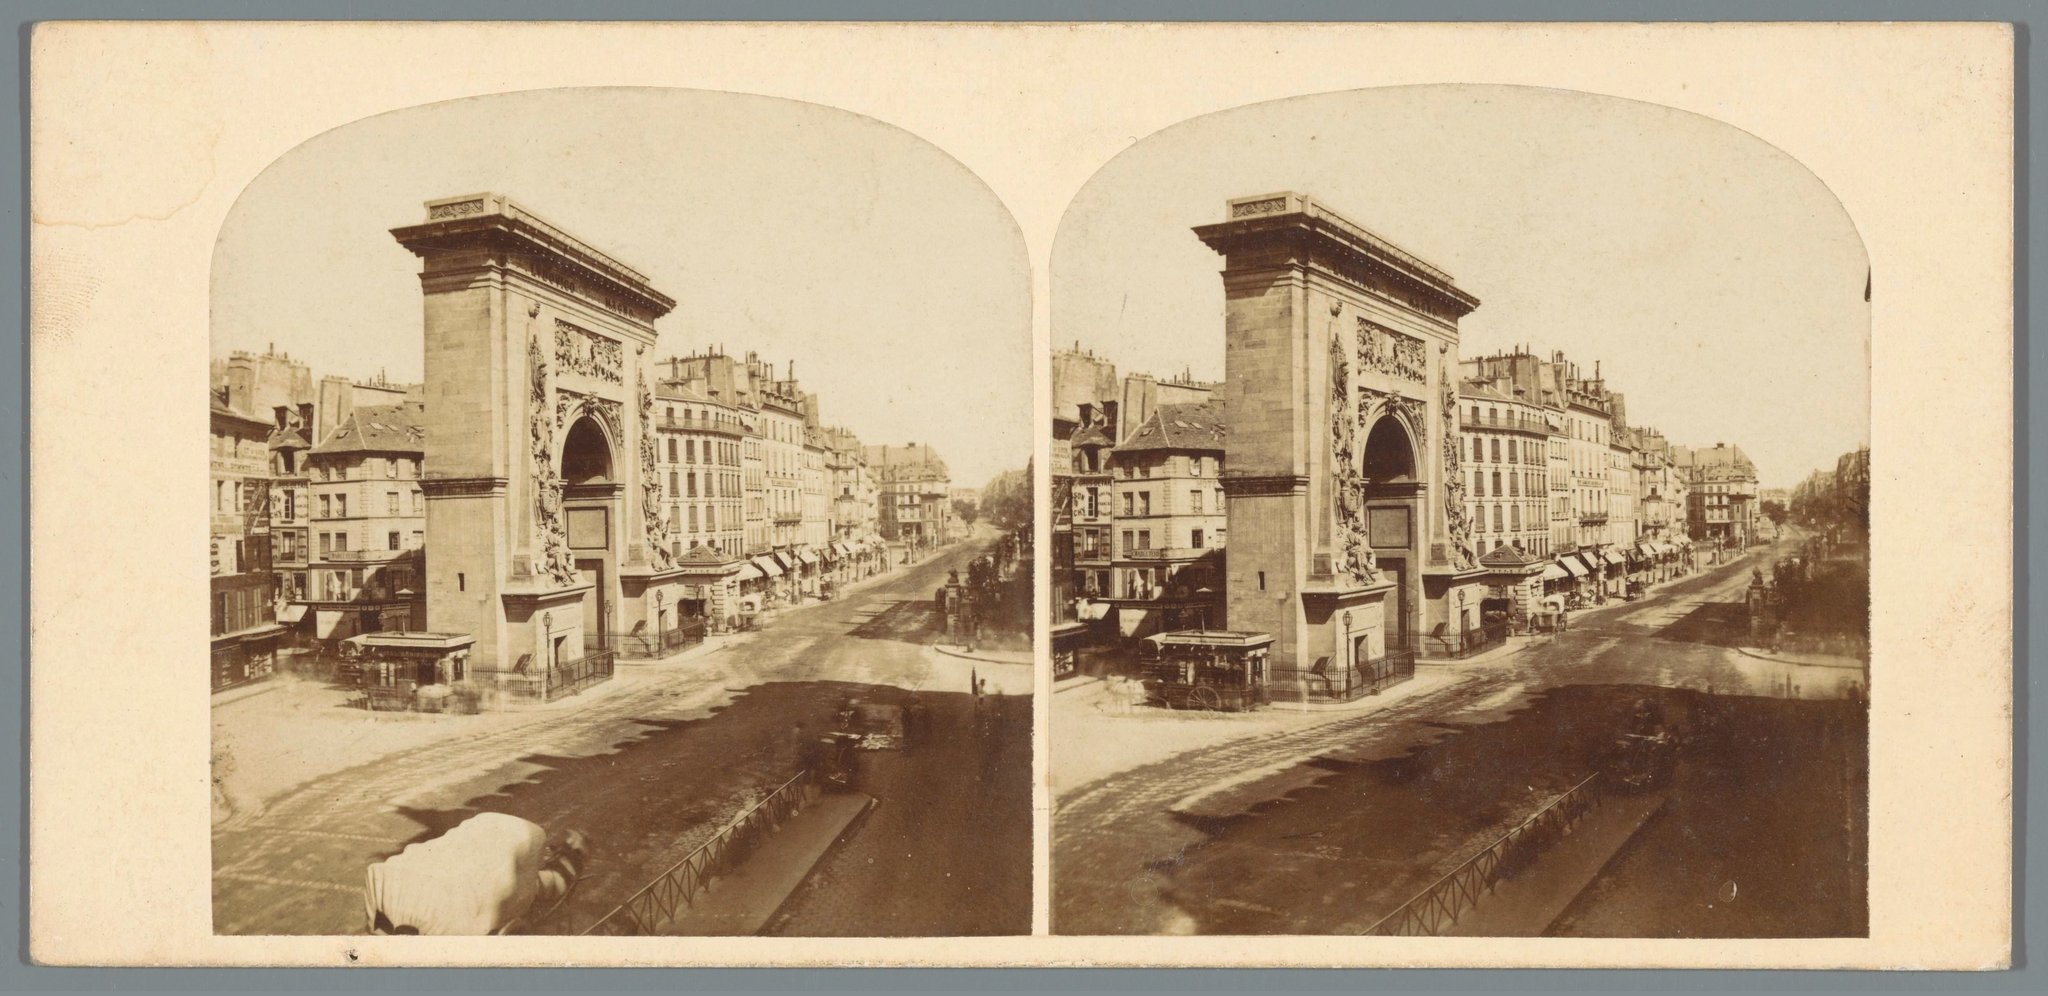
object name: stereograph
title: Paris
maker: Anonymous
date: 1850-1880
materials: cardboard, photographic support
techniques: albumen print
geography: paris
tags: street, city-gate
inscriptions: inscription: ‘3 ize Boulevard St Denis’